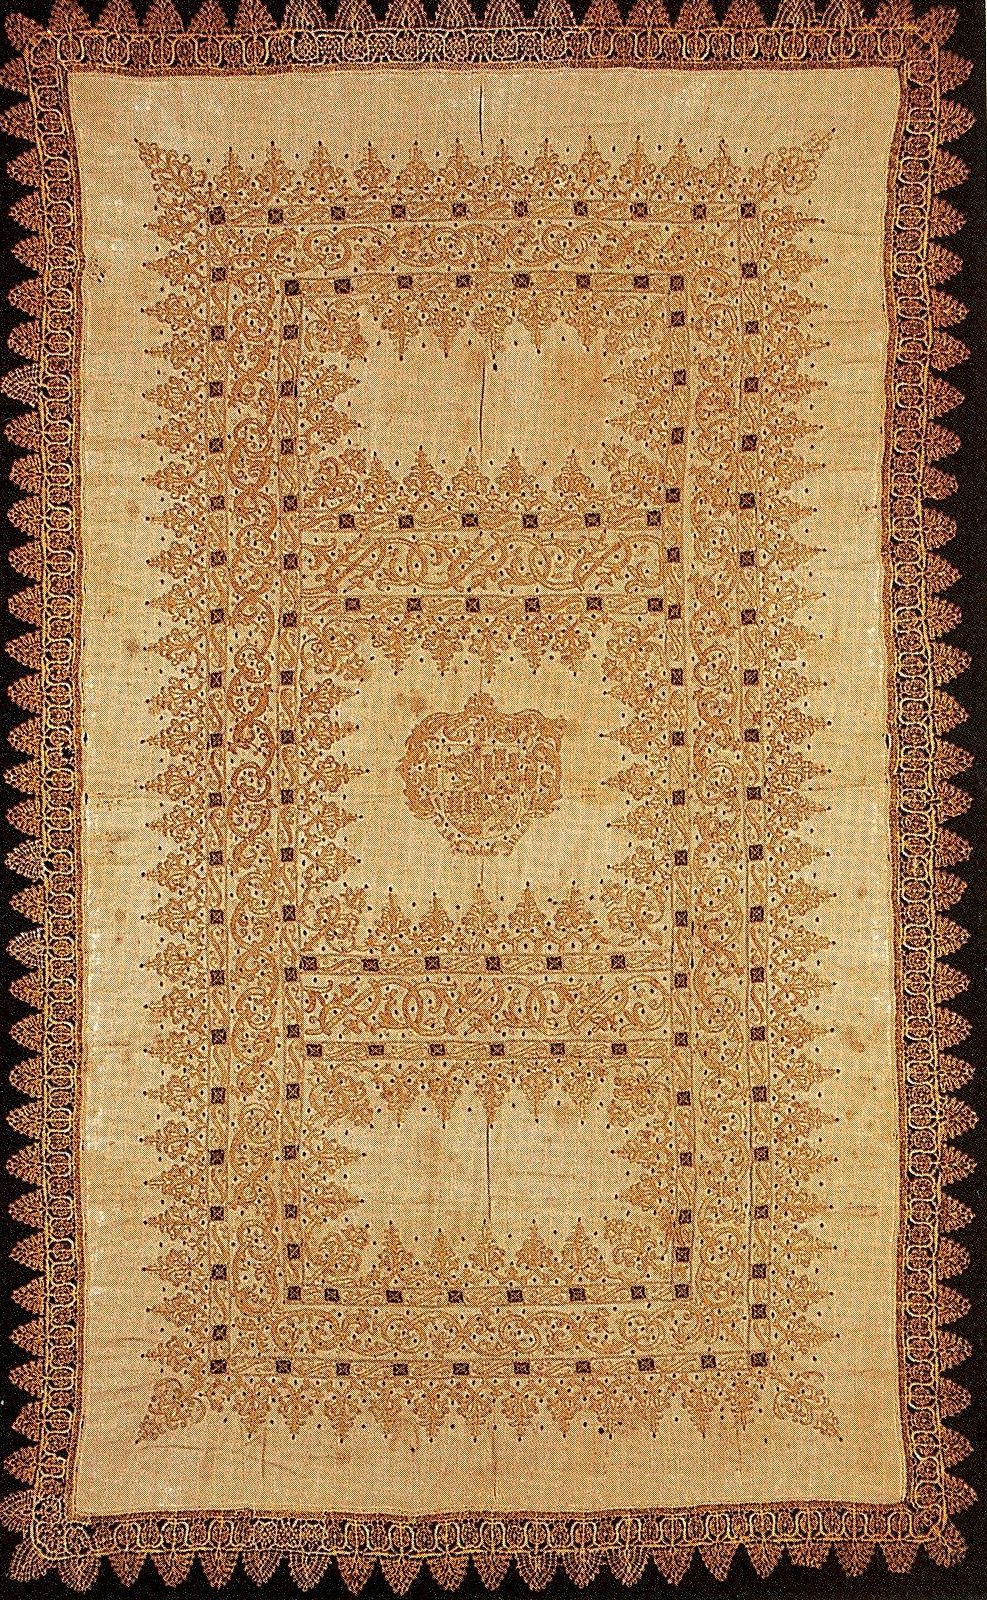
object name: tablecover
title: Table Cover with a Coat of Arms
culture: spanish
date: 1501-1600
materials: fiber, linen, silk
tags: coat of arms